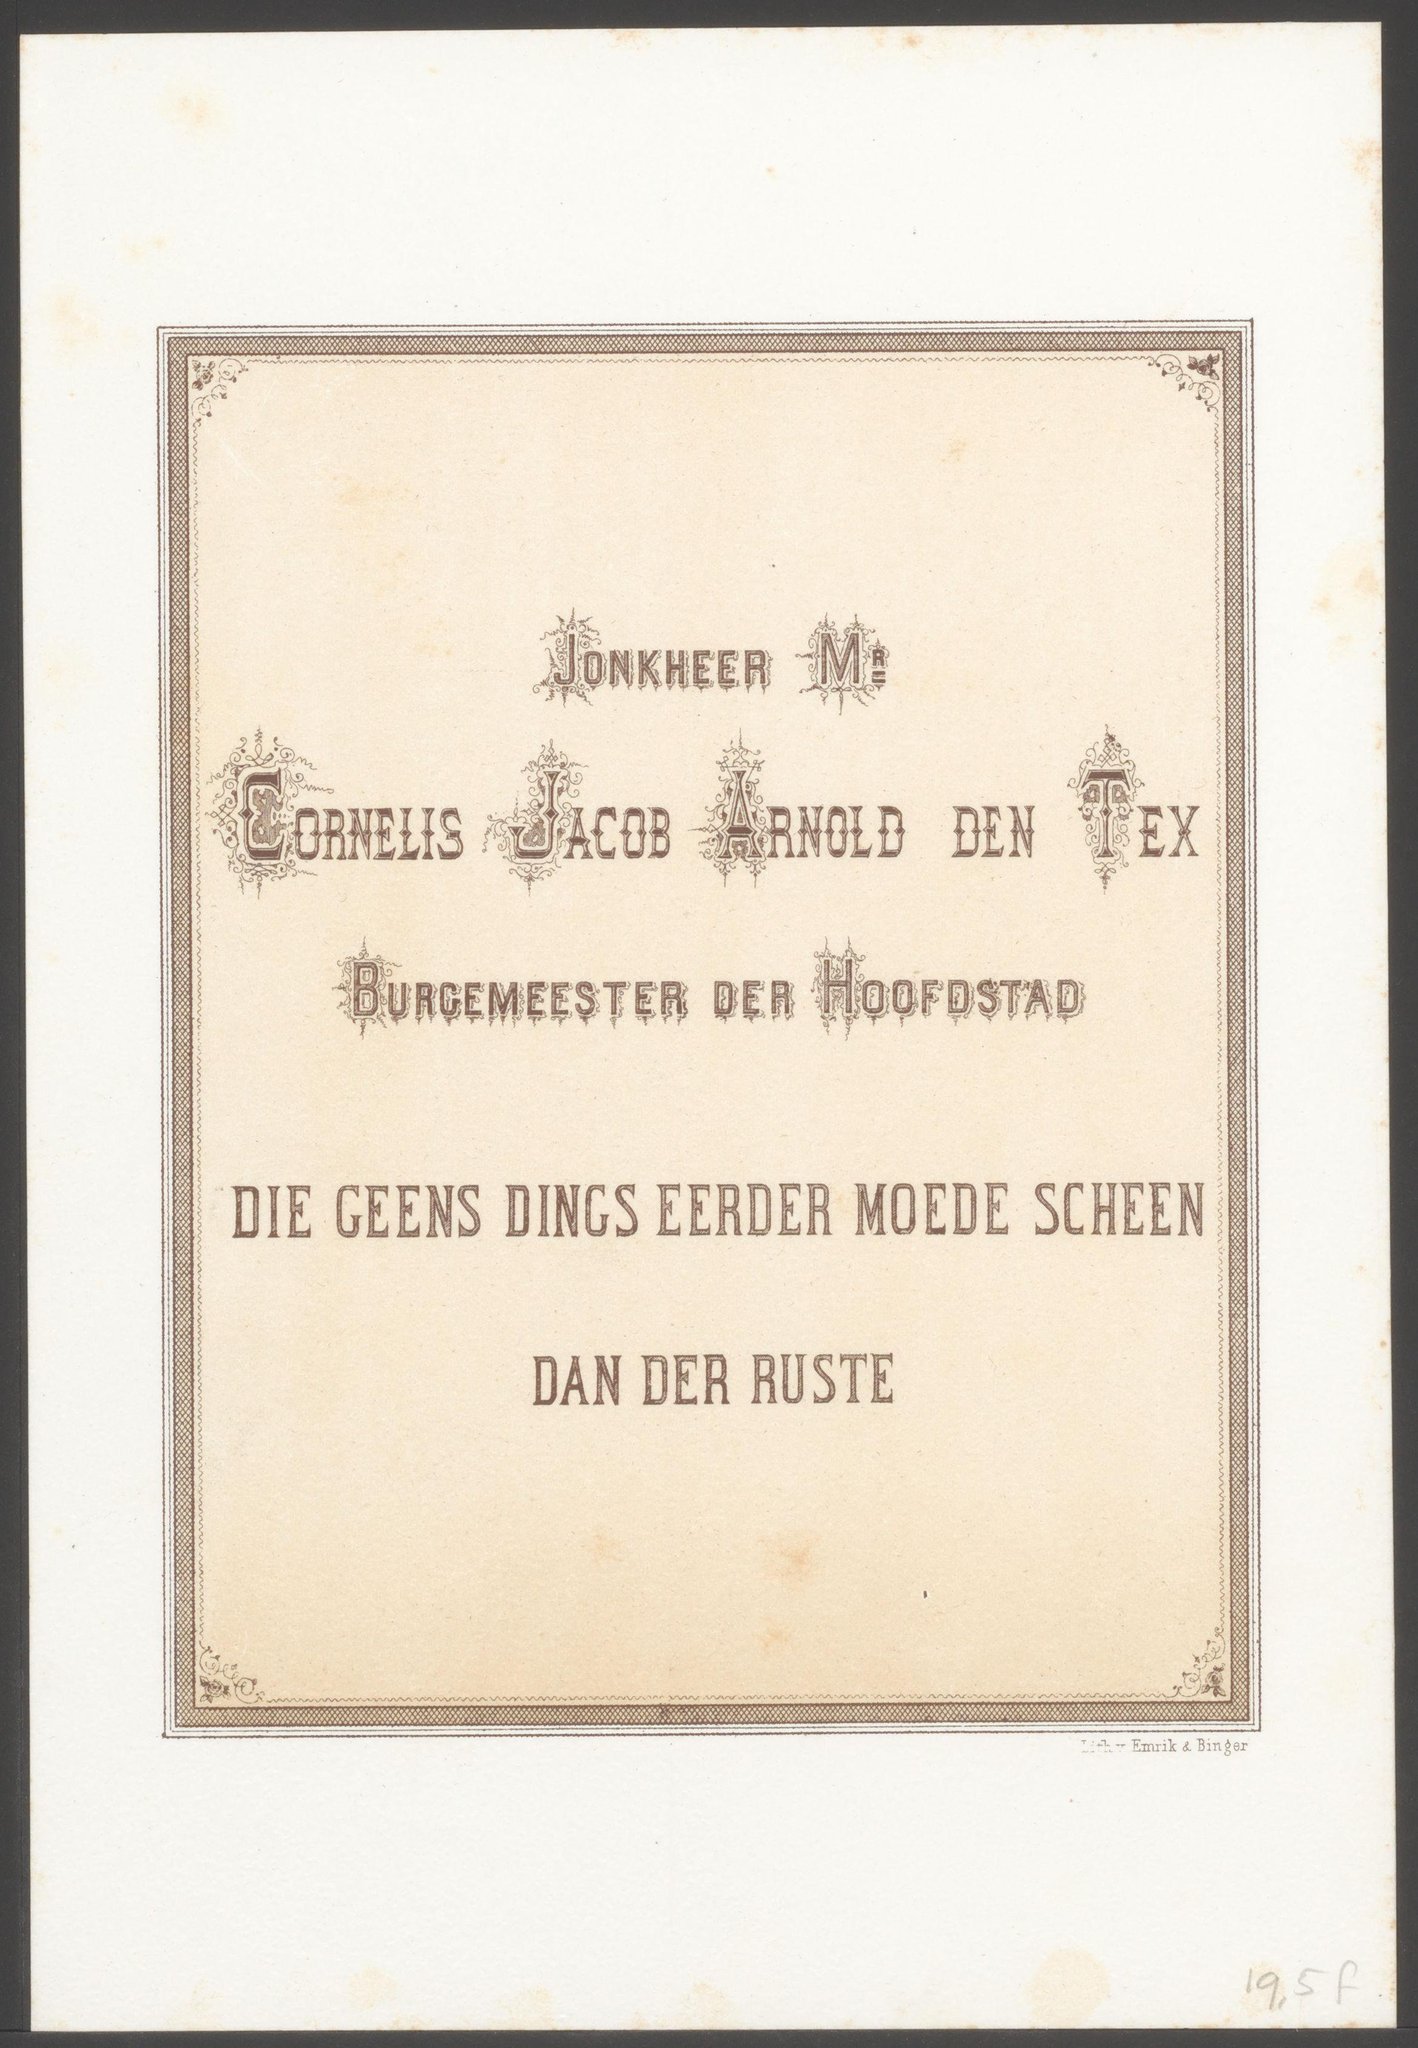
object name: print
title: Lofdicht op Cornelis Jacob Arnold den Tex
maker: Anonymous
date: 1880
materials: paper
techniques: tone lithography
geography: haarlem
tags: cornelis jacob arnold den tex, mayor, burgomaster, commemoration, jubilee, amsterdam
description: Onderwerpsrubriek binnen de Atlas Amsterdam: Herinneringen aan regeringsleden en hunne huisgezinnen [na 1800]. Onderdeel van een boekje gedrukt ter gelegenheid van het afscheid van Cornelis Jacob Arnold den Tex als burgemeester van Amsterdam op 31 december 1879.